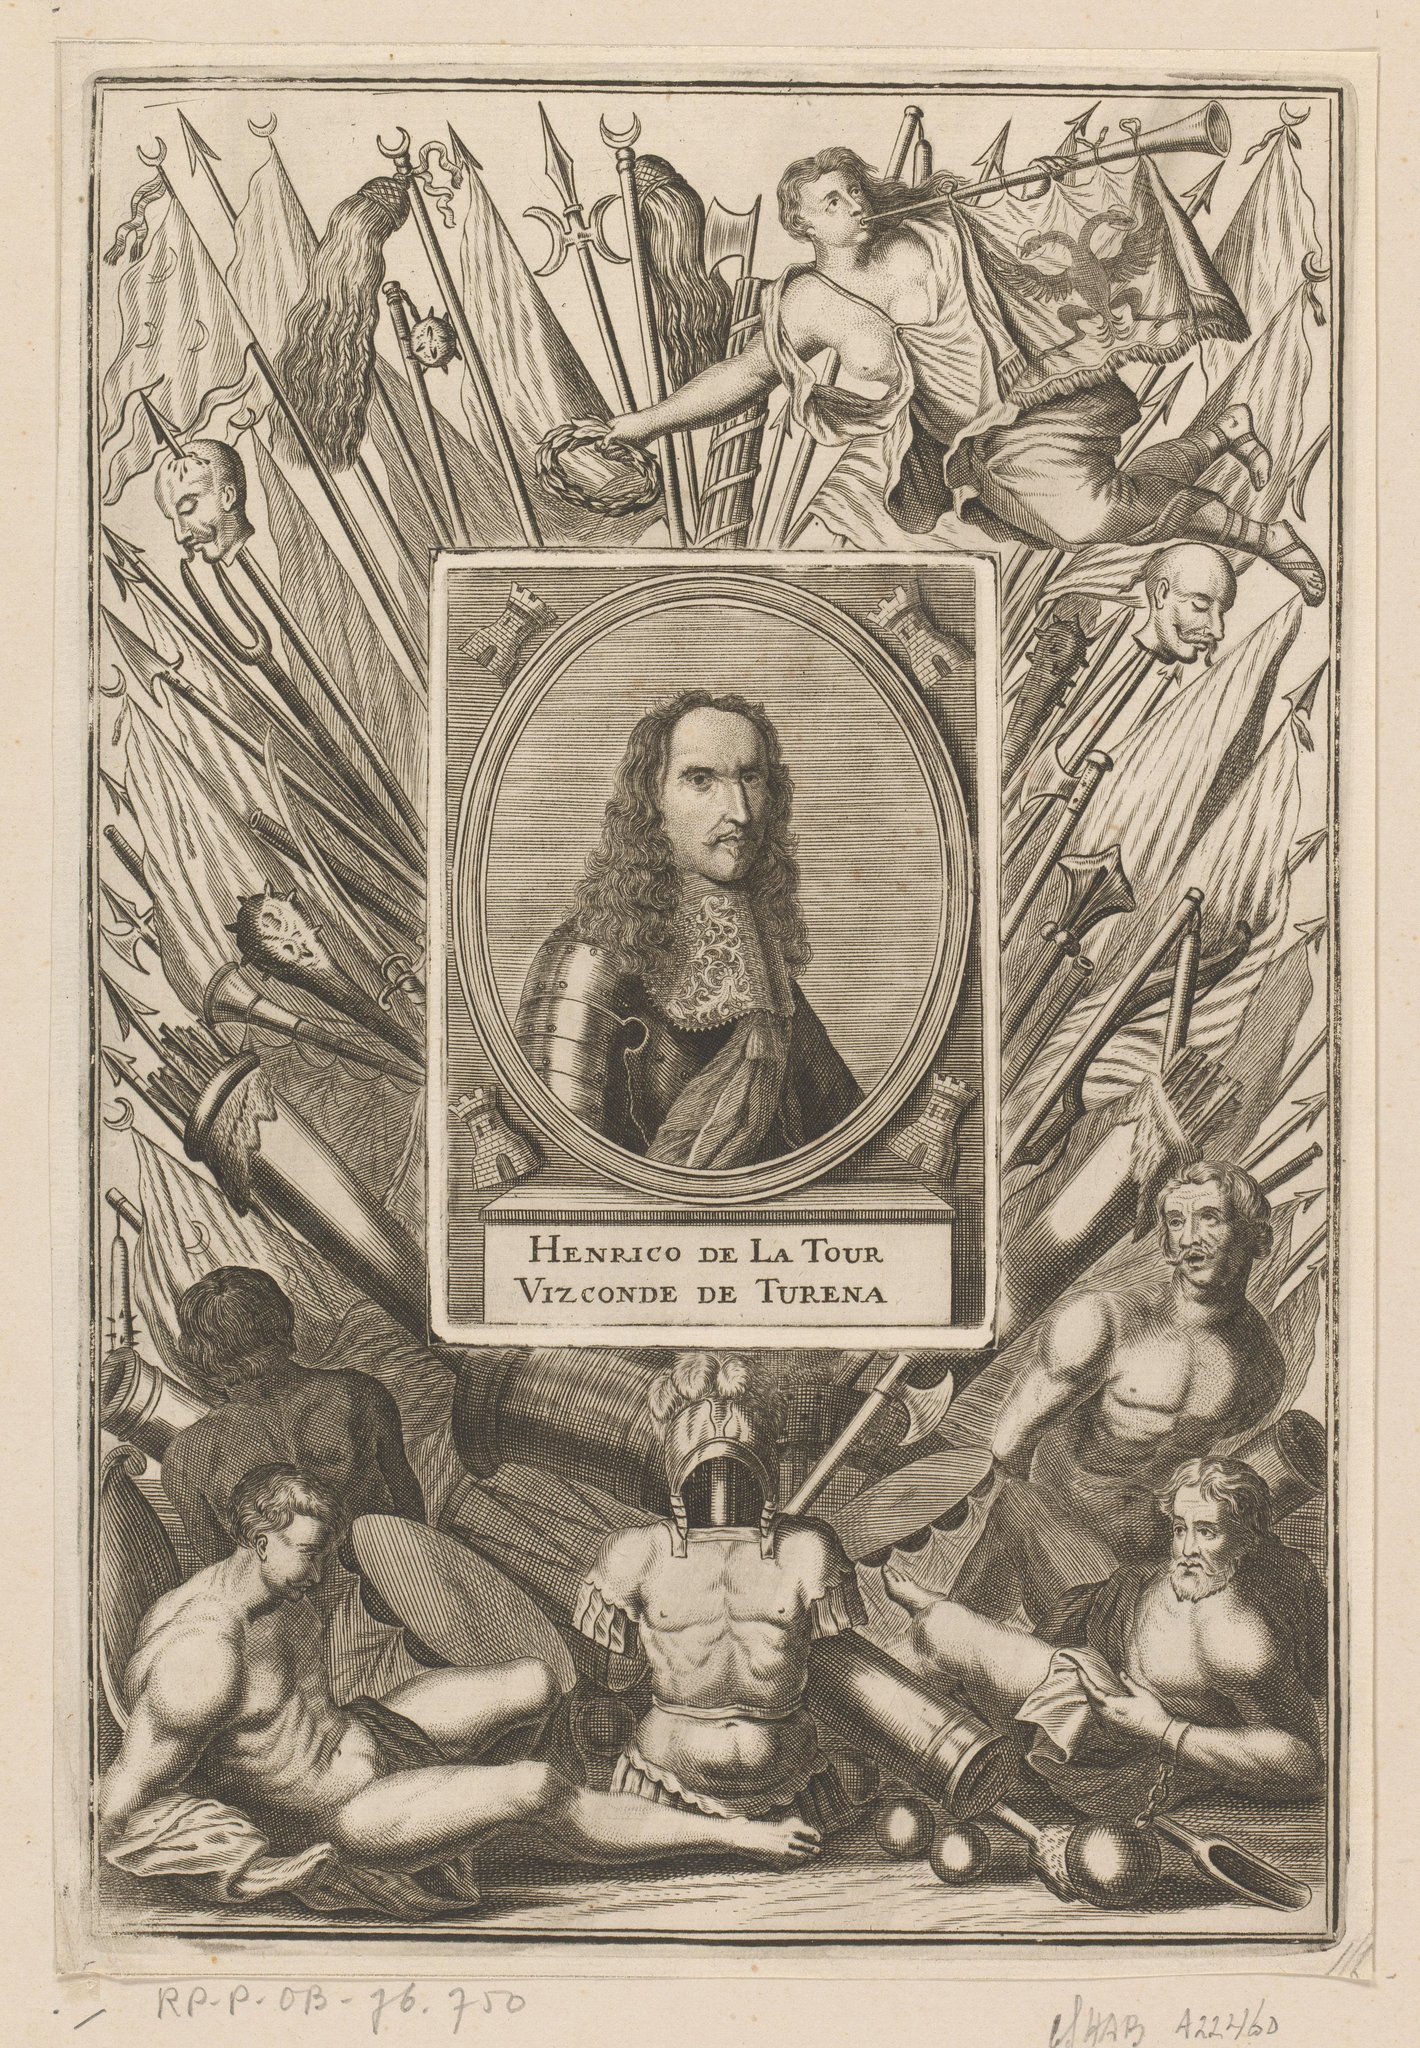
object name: print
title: Portret van Henri de la Tour d'Auvergne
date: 1735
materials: paper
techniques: engraving, etching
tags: ranks in the army, historical persons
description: Prent waarschijnlijk uit: Roncaglia, Constantino. Admirables efectos de la Providencia (...). Antwerpen: Hendrik Verdussen, 1735, dl. 2.